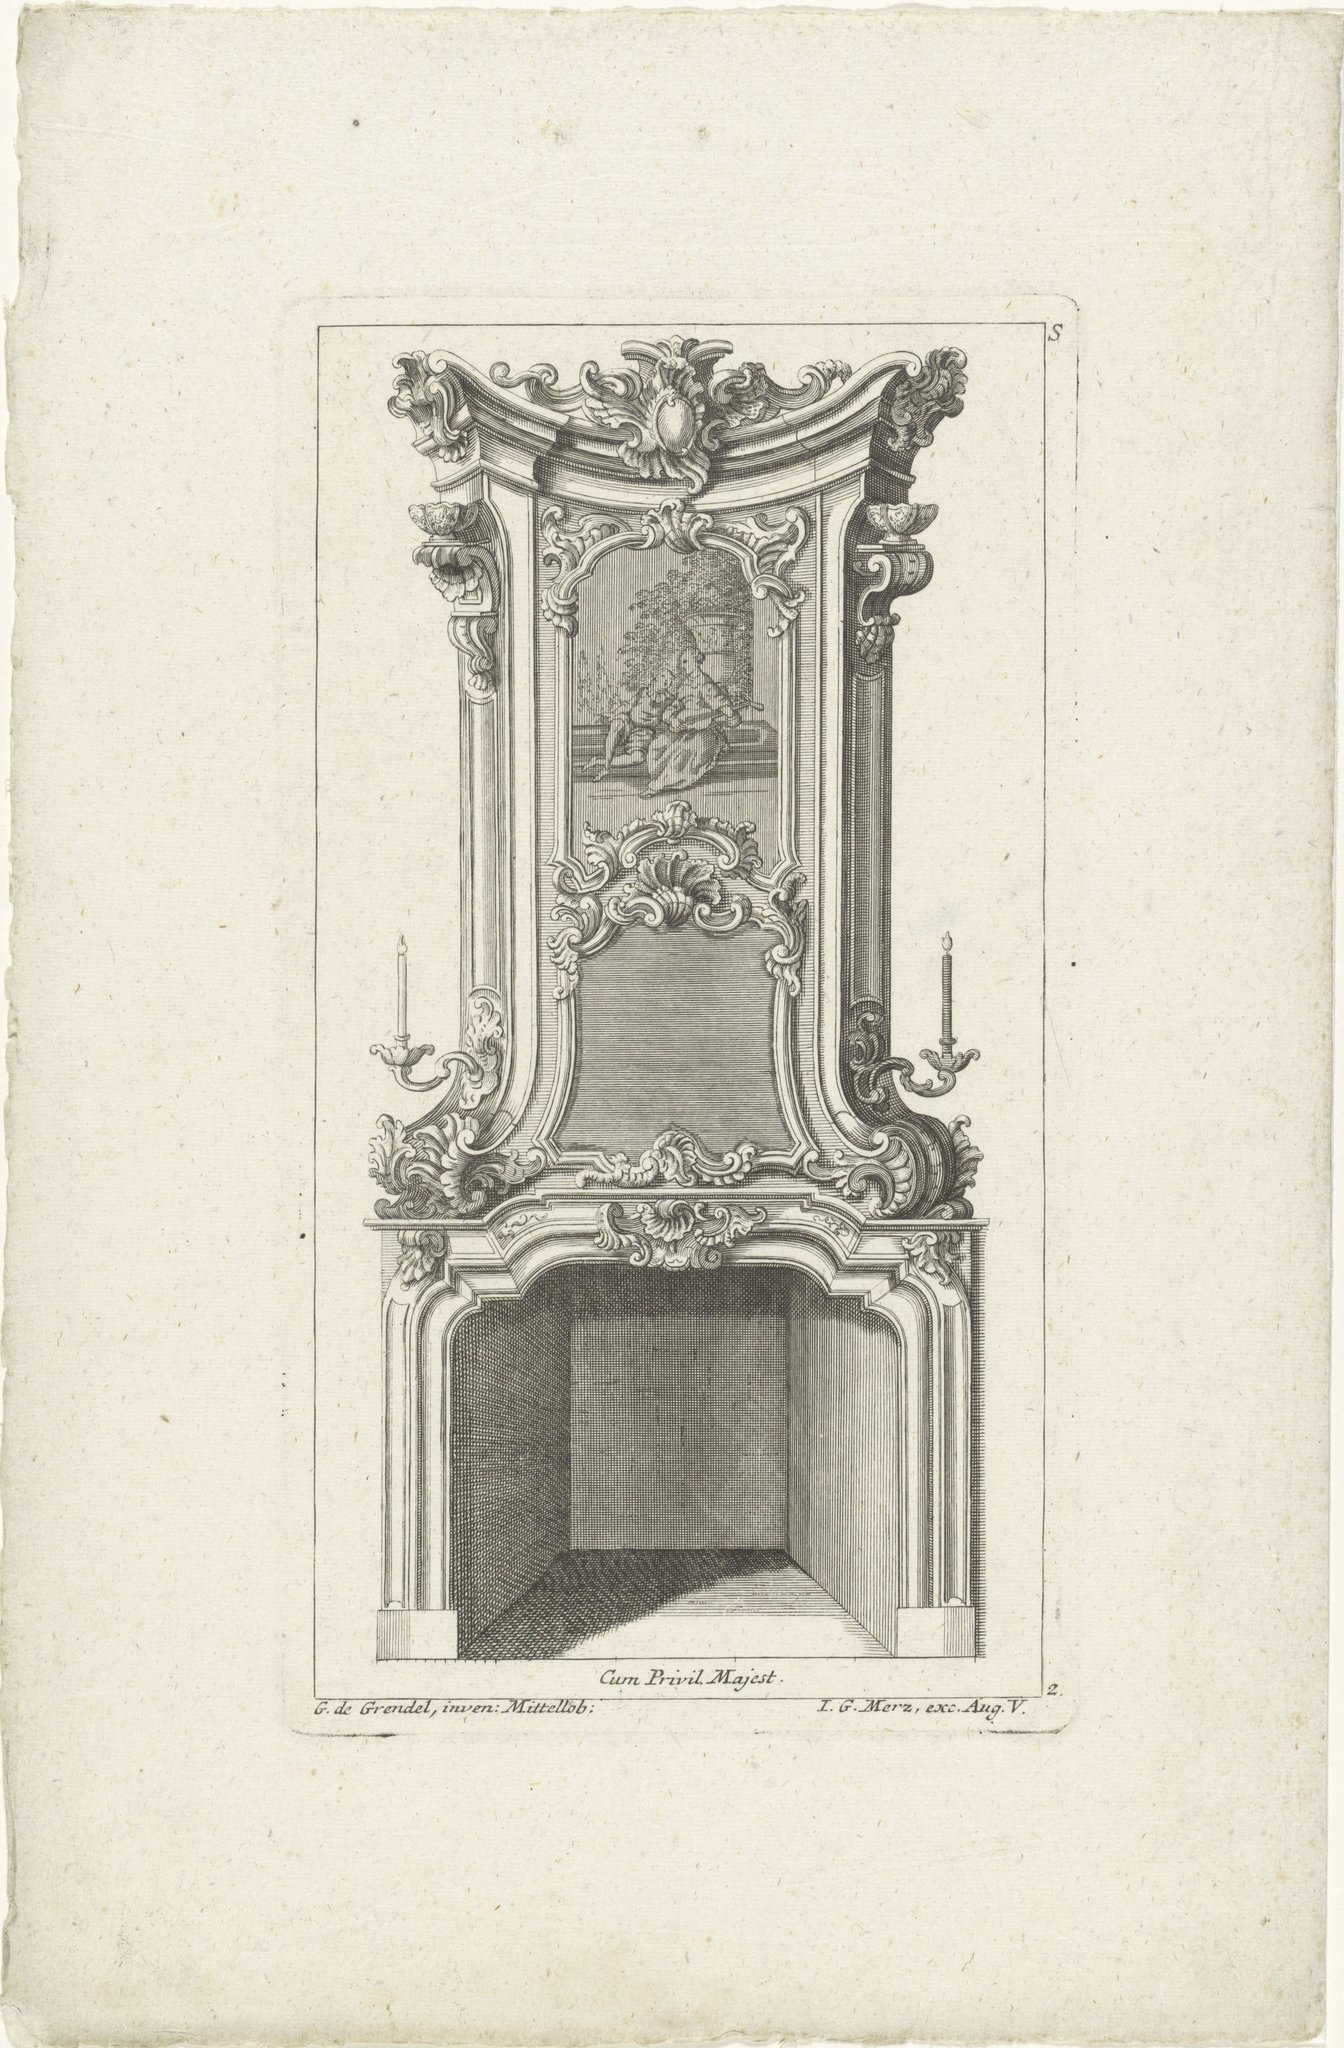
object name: print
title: Ontwerp voor een schoorsteen met voorstelling van een musicerend paar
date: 1709-1762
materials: paper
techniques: engraving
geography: augsburg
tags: chimney, rocaille ornament, cithern, mandolin, guitar, balalaika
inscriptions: collector's mark: Lugt 2228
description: Ontwerp voor een schoorsteen met een voorstelling van een vrouw die een gitaar bespeelt en een zingende jongeman. Zij zitten voor een tuinvaas. De schoorsteenmantel is versierd met rocailleornamenten en voluten. Aan weerzijden een kandelaar.